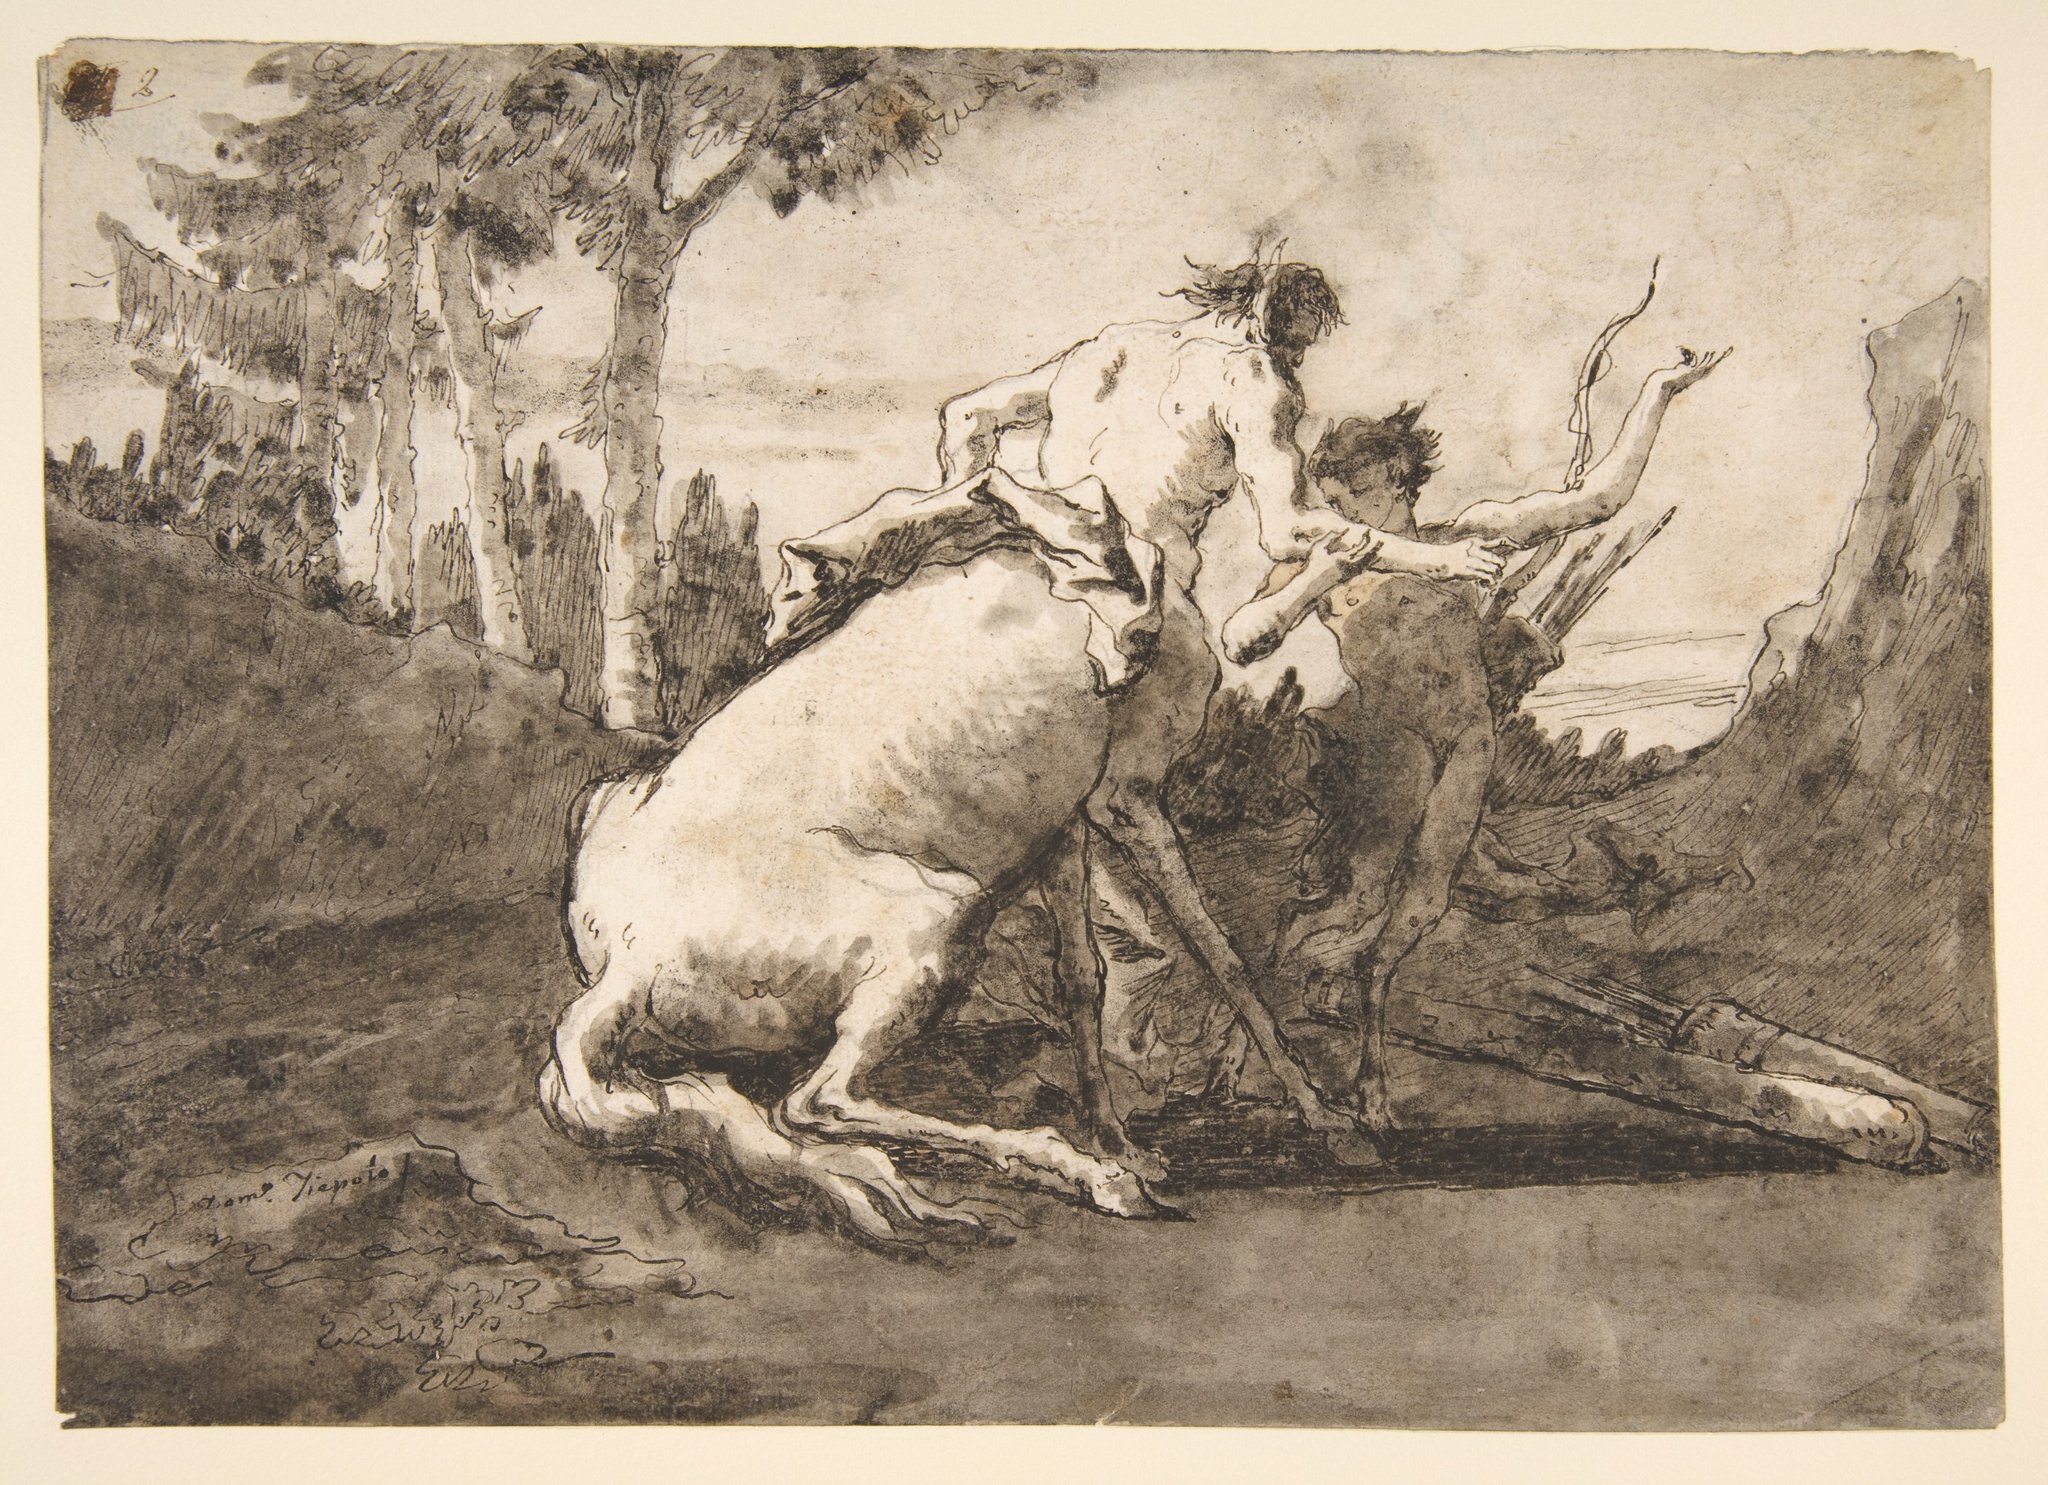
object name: drawing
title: Centaur with a Young Satyr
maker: giovanni domenico tiepolo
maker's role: artist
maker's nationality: italian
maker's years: 1727-1804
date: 1727-1804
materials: graphite, ink, lead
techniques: brush, pen, wash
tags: centaurs,satyrs,trees